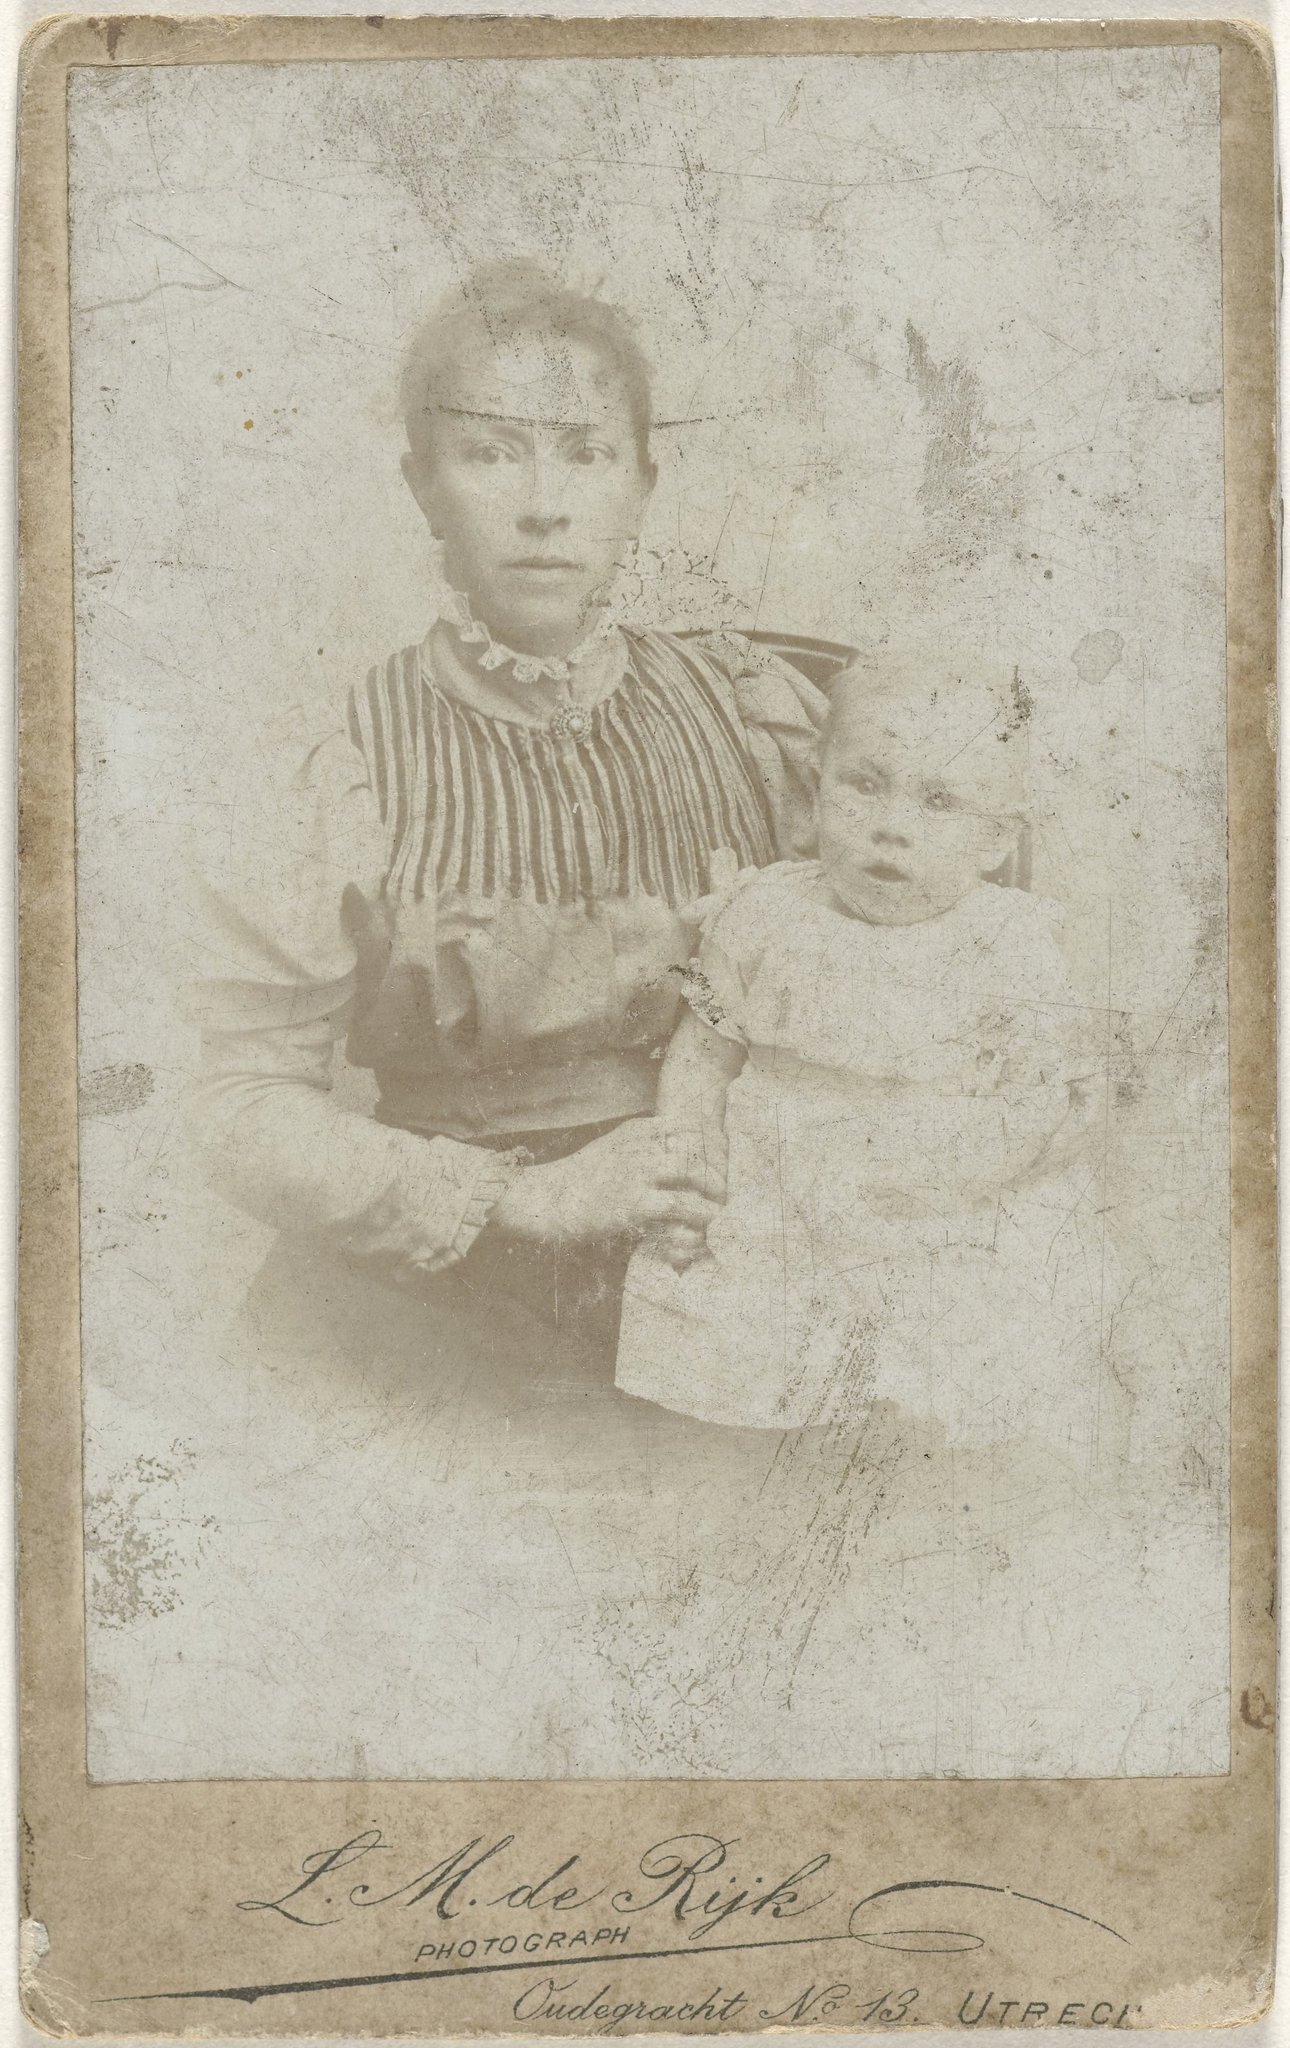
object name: photograph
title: Studioportret vrouw met baby op schoot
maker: l.m. de rijk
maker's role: fotograaf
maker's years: 1869-1936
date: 1880-1920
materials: cardboard, photographic support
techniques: collodion silver print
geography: utrecht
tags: utrecht